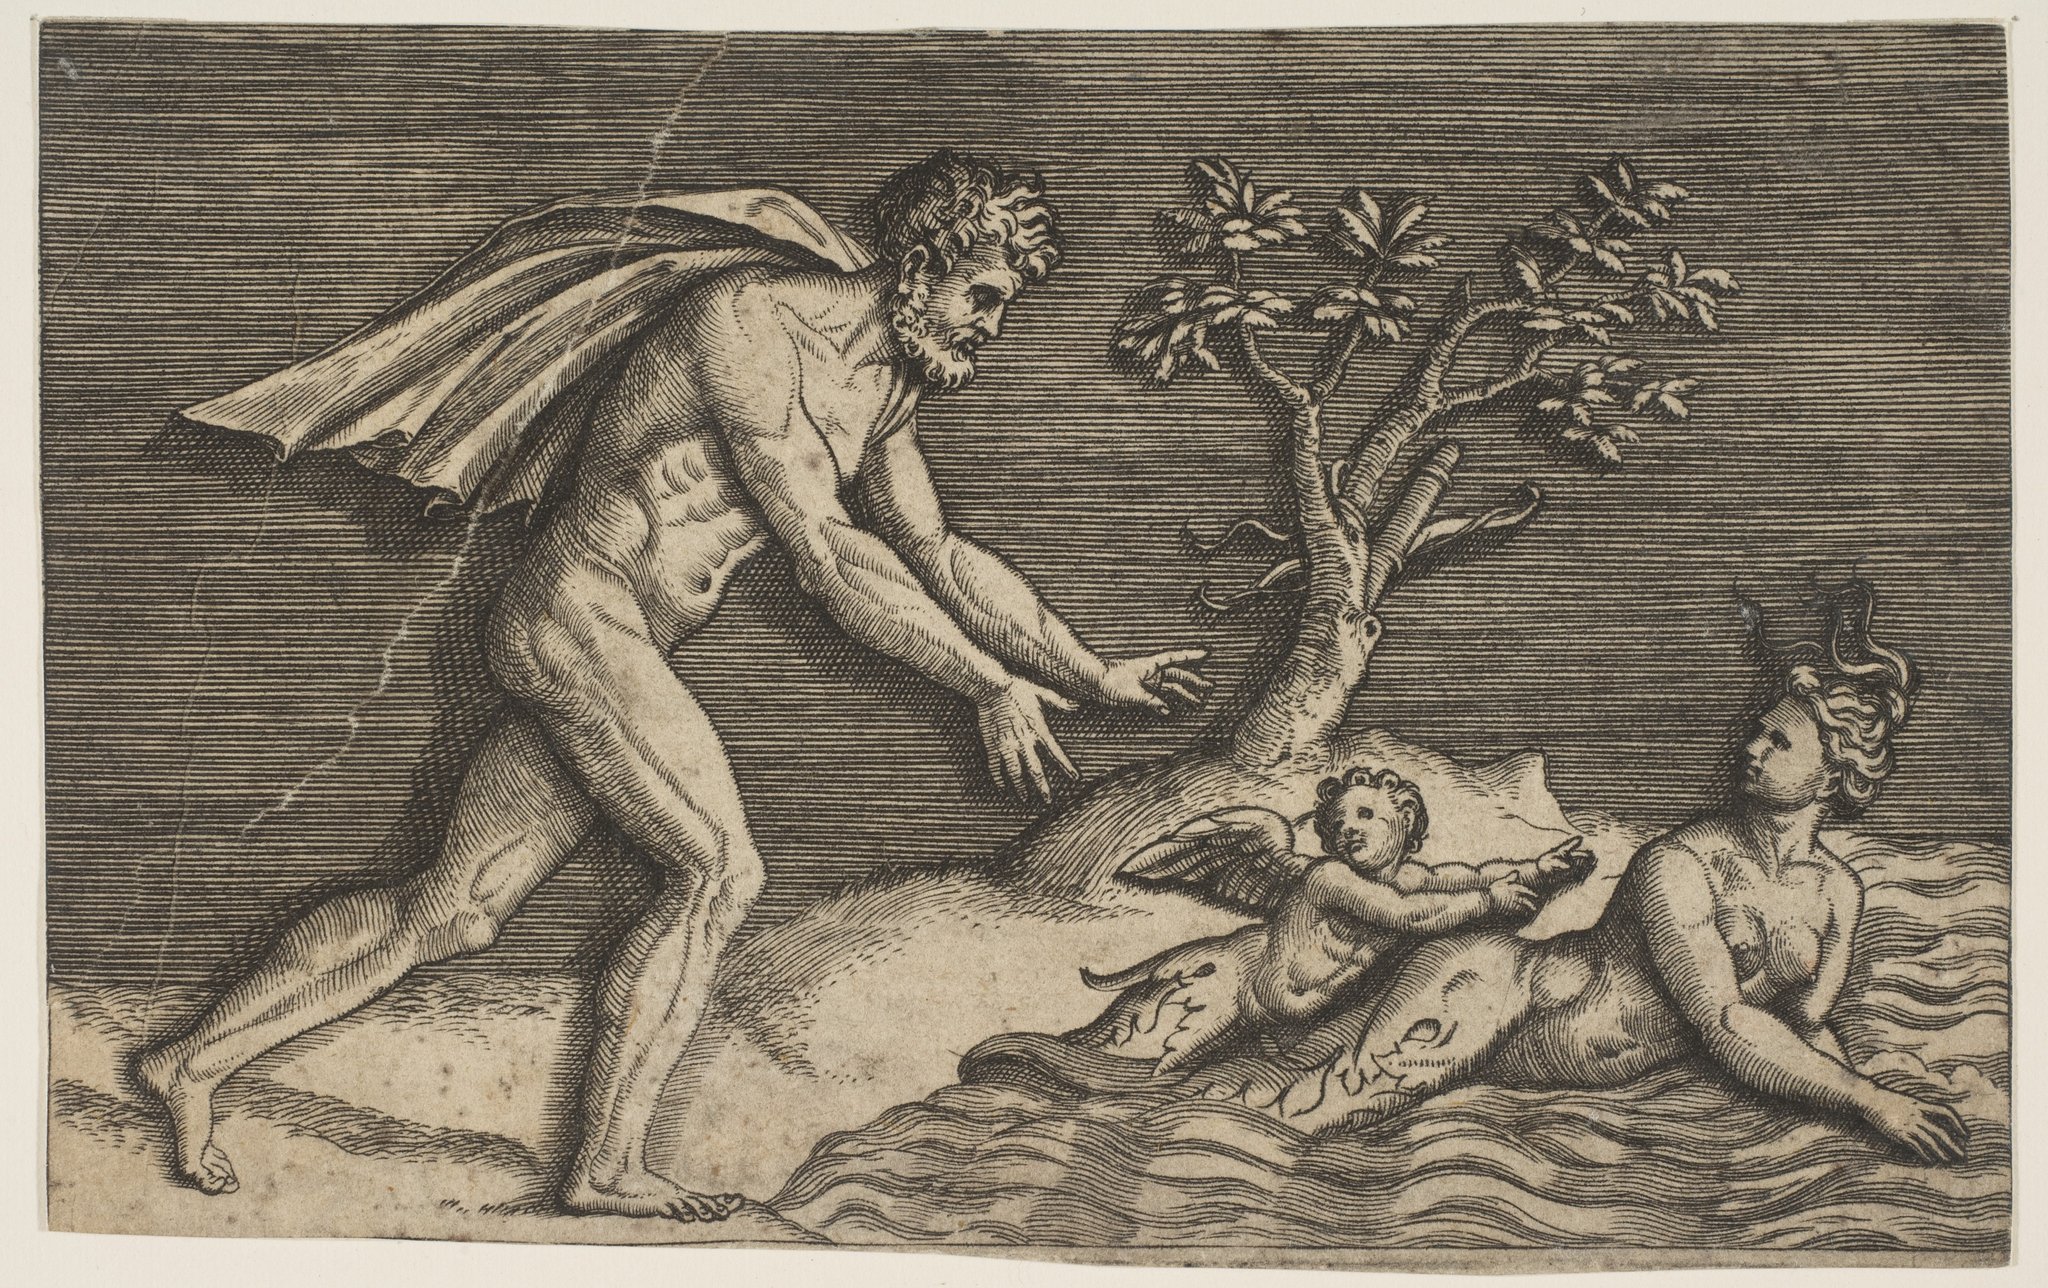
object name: print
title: A naked man pursing a naiad and a cupid into the water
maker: marco dente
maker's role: artist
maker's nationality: italian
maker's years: 1515-1527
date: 1515-1527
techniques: engraving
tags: male nudes,cupid,nymphs,trees